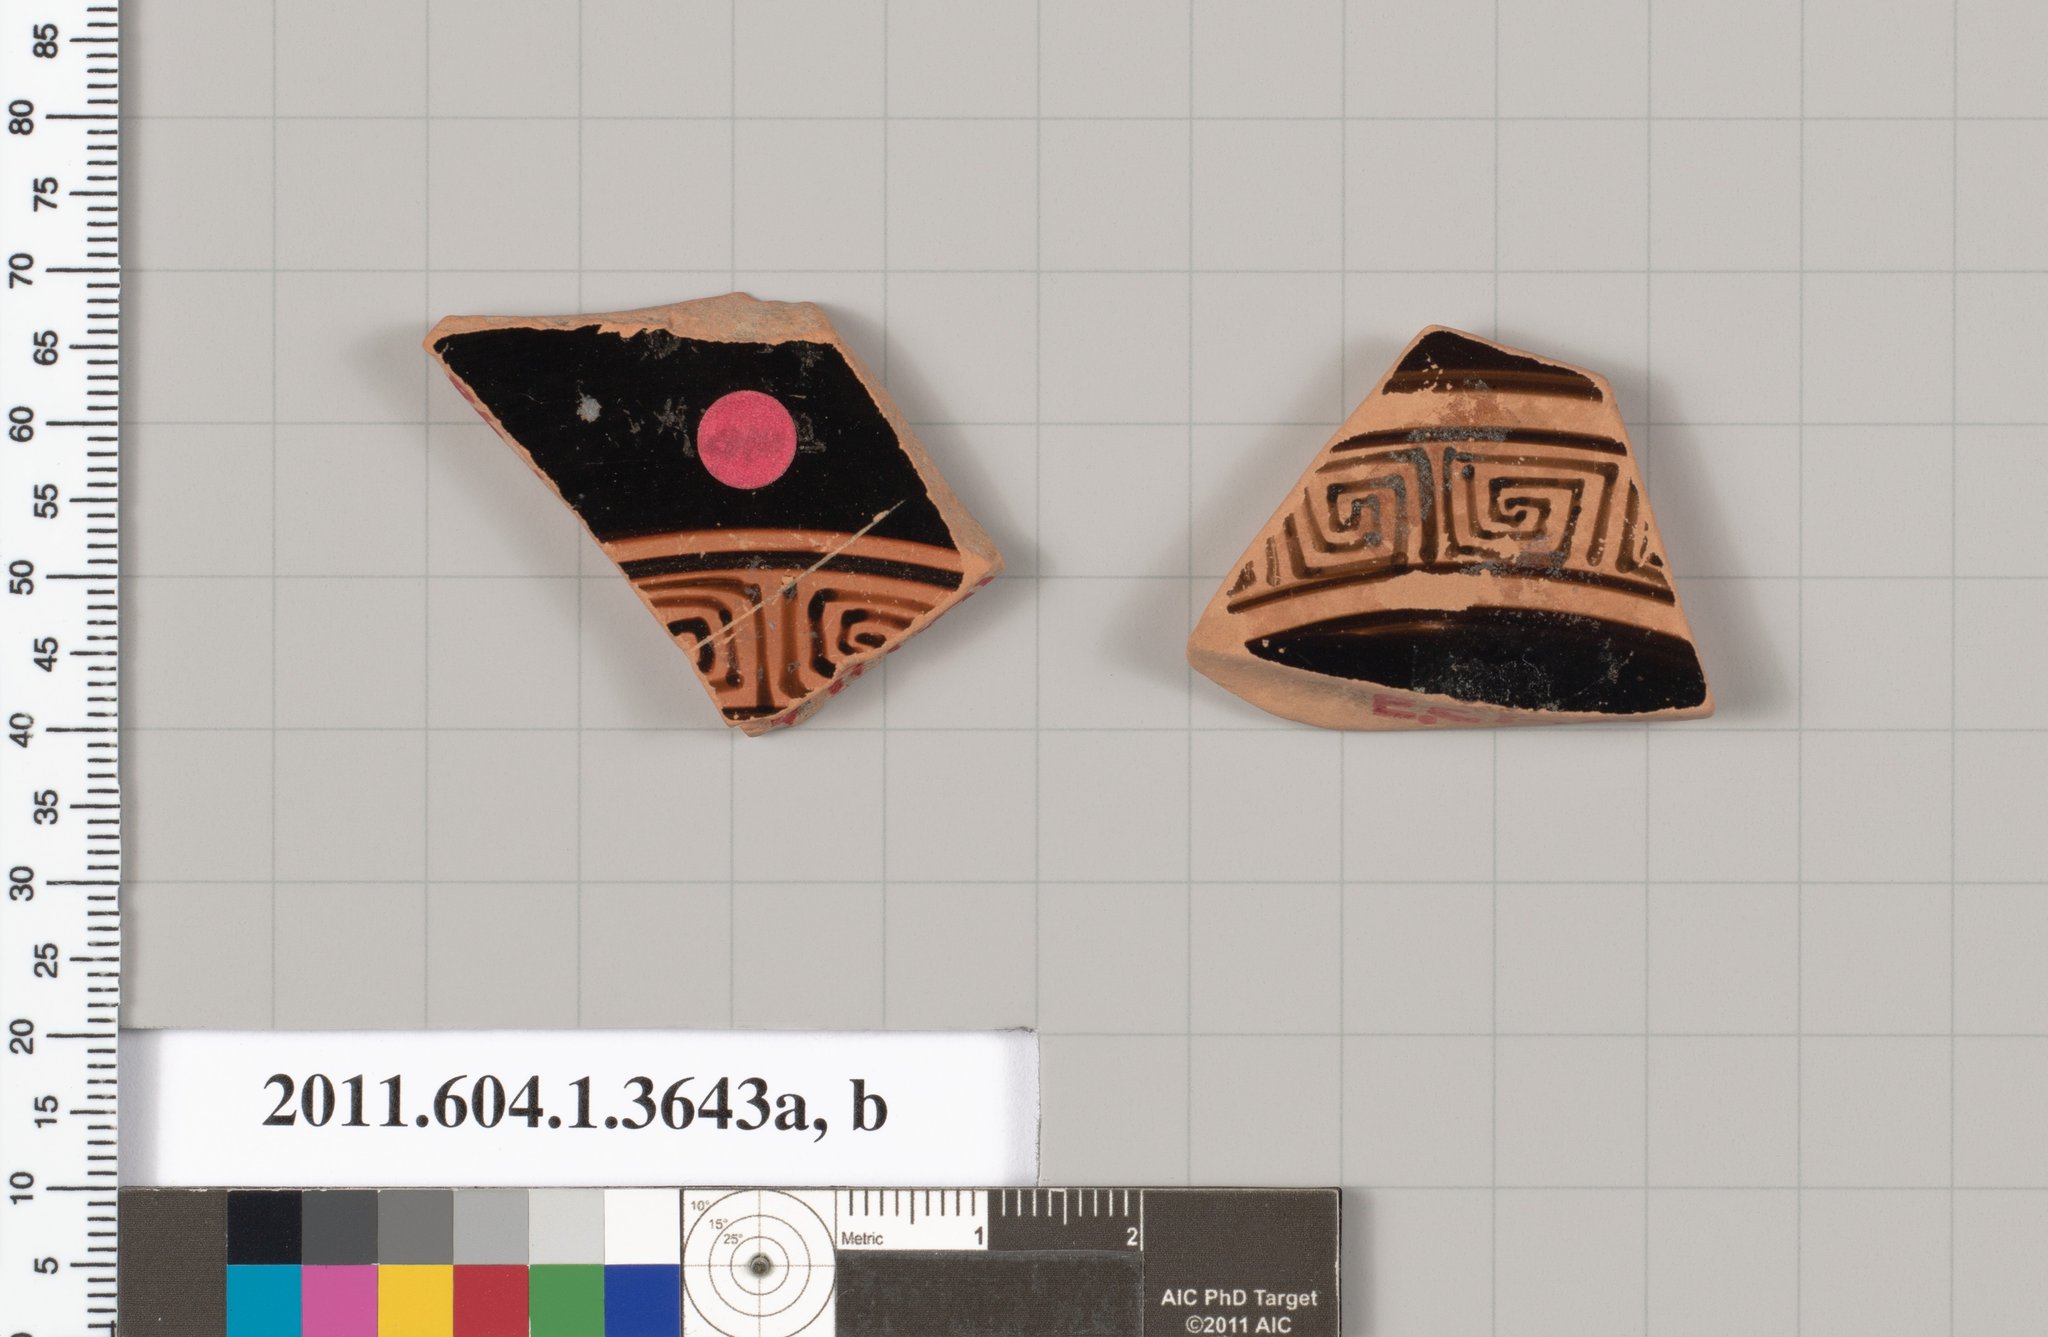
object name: kylix fragment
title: Terracotta fragments of kylikes (drinking cups)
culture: greek, attic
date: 475-451 BCE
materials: terracotta